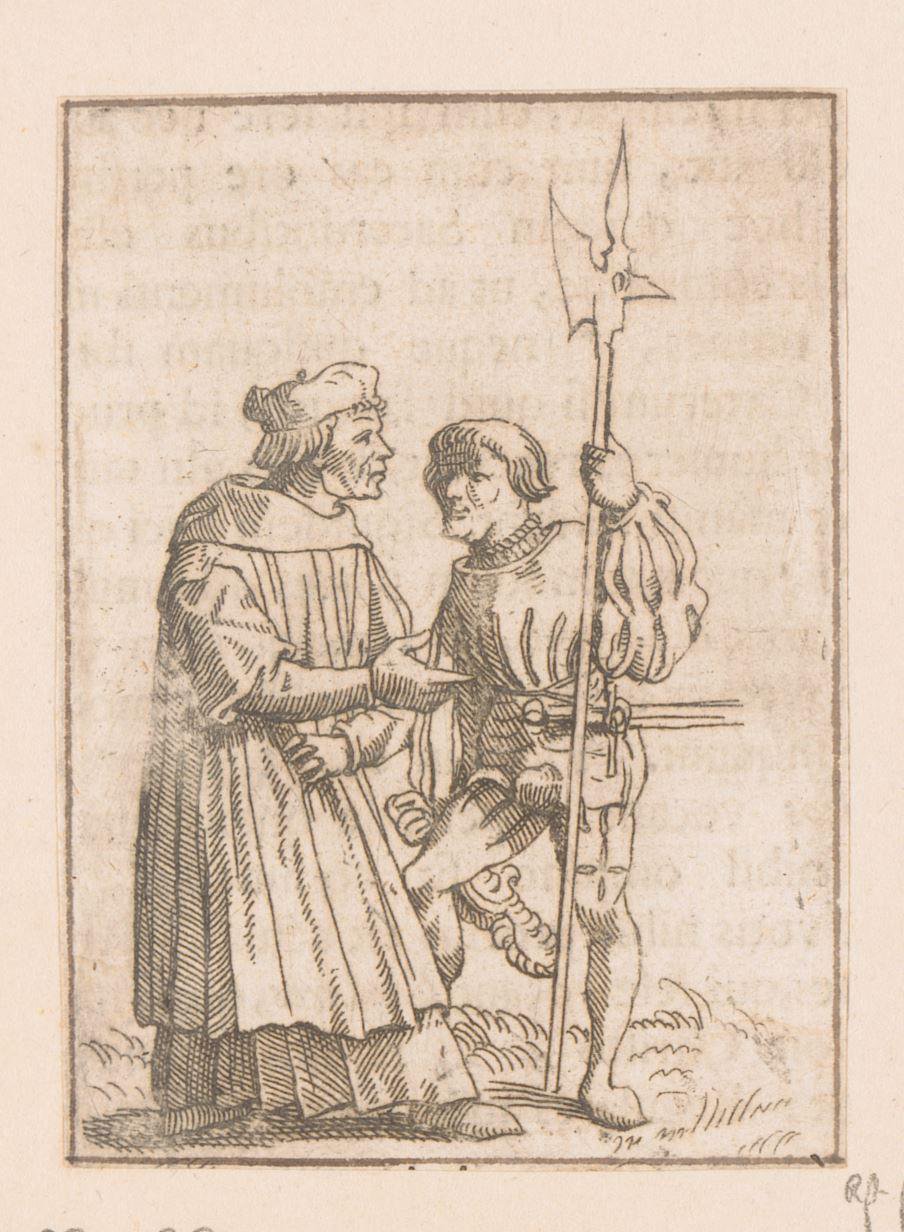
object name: book illustration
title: Illustraties uit de Lof der Zotheid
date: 1516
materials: paper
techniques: etching, letterpress printing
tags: theologian, the soldier; the soldier's life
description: Prent afkomstig uit: Erasmus, Desiderius. Morias enkomion (...). Bazel: Johann Rudolf Genath, 1676. De prenten hierin zijn naar tekeningen die Hans en Ambrosius Holbein maakten voor de theoloog Oswald Myconius in diens uitgave van de Moriae encomium (Lof der Zotheid) van 1516.